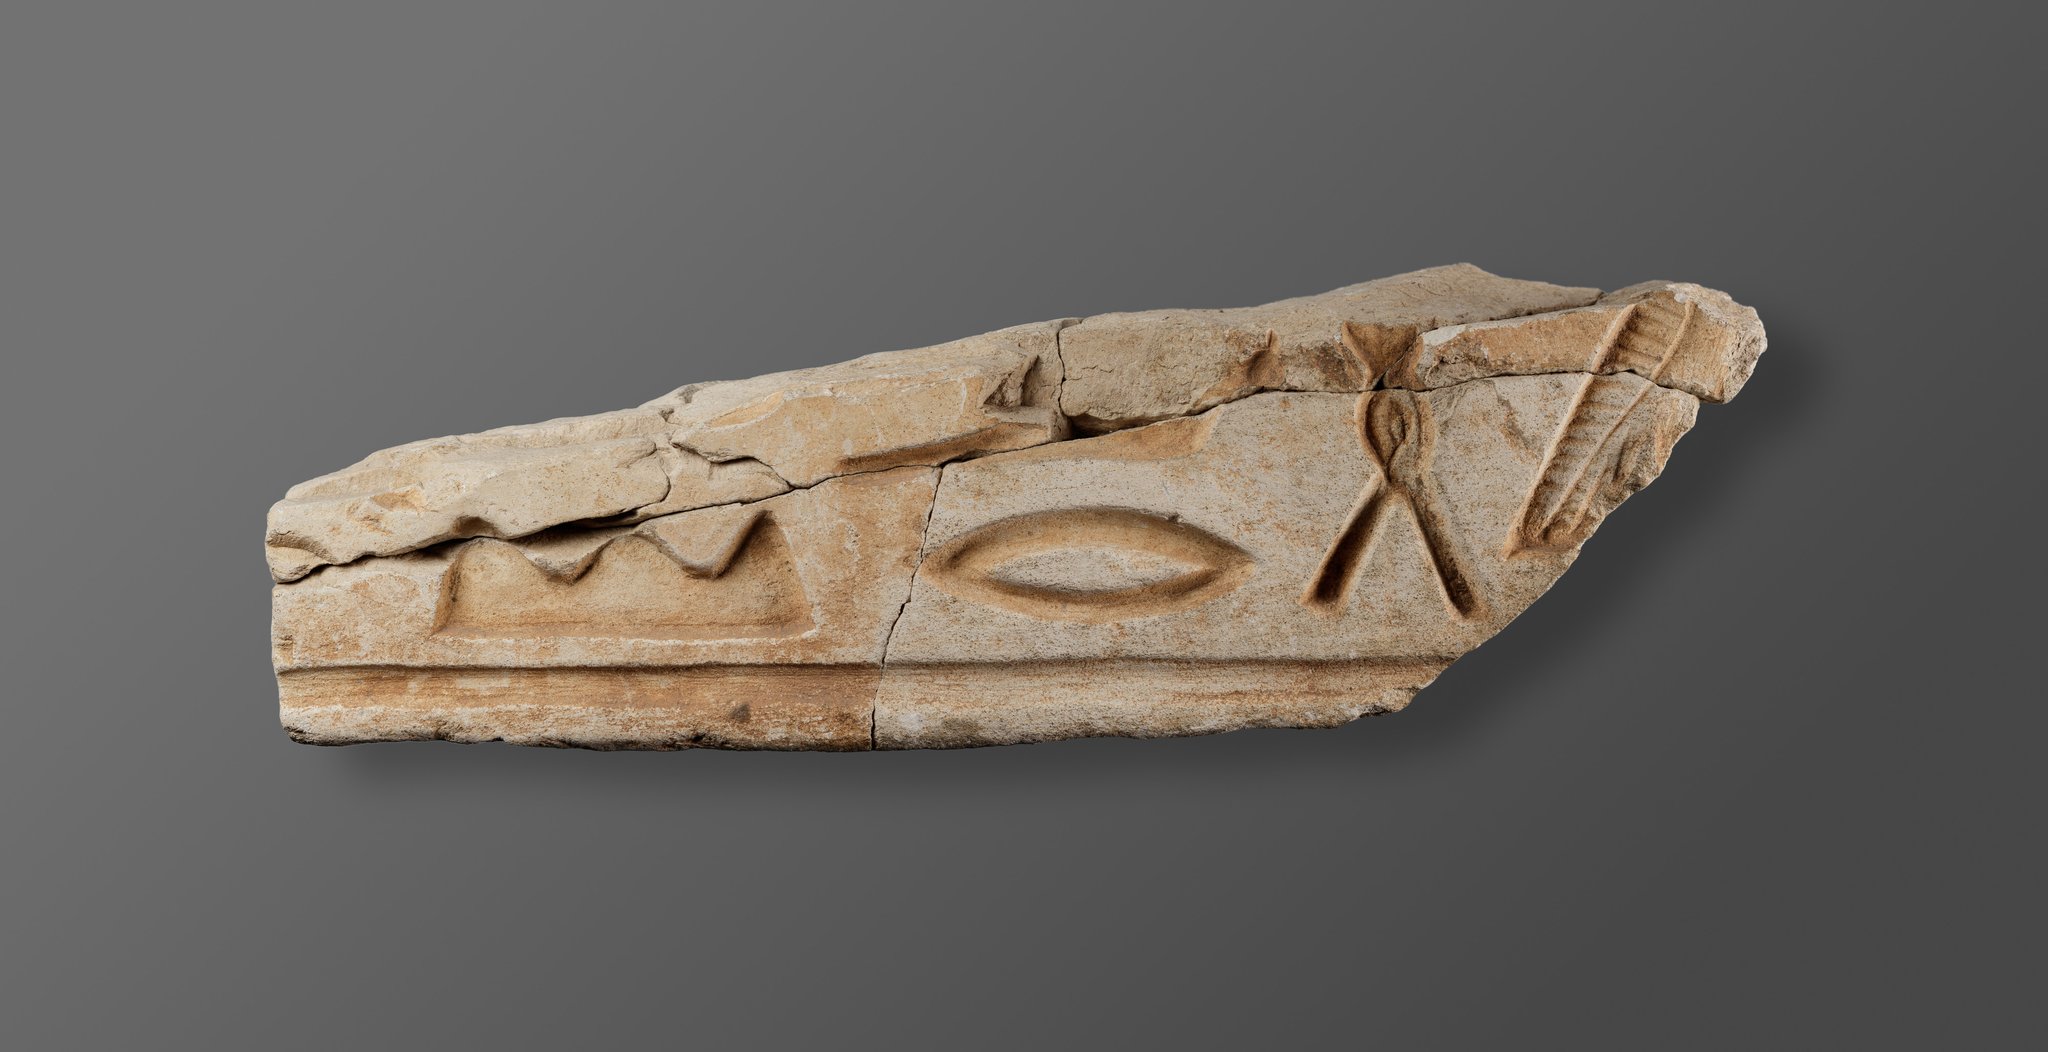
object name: relief fragment 47, tomb of mereri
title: Relief fragment possibly from the tomb of Mereri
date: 2100-2090 BCE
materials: stone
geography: egypt